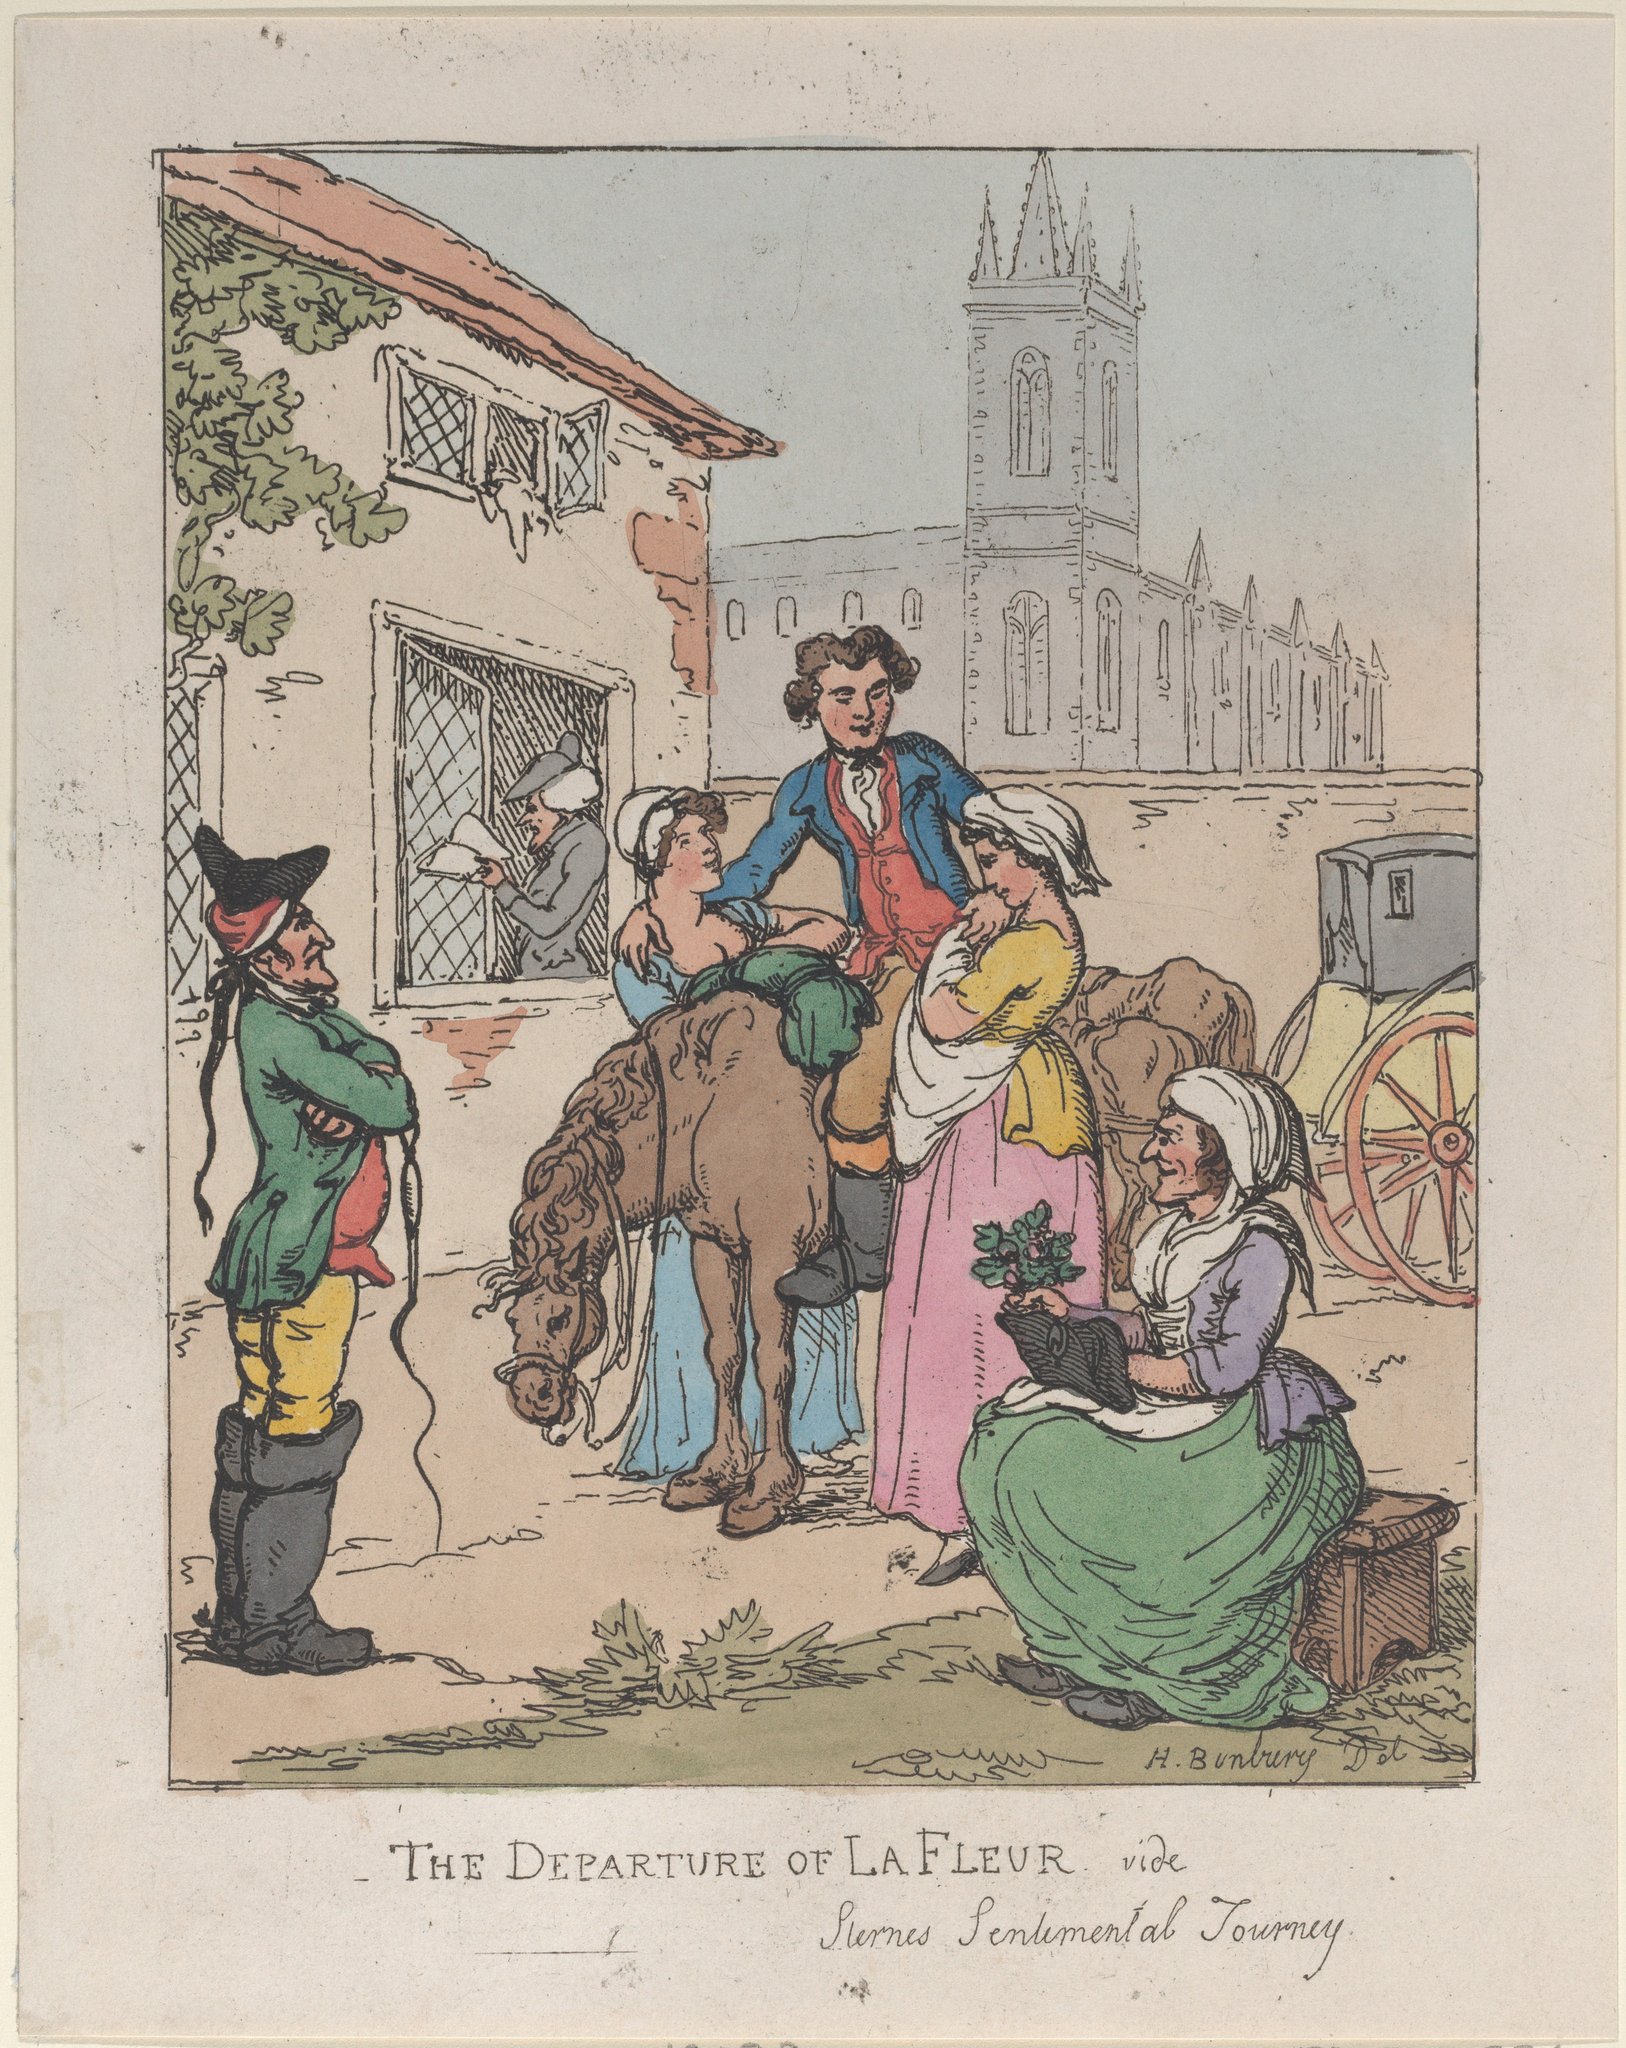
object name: print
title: The Departure of La Fleur, Sterne's "Sentimental Journey"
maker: thomas rowlandson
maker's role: artist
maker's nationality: british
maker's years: 1757-1827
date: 1809-1811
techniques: etching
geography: london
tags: men,women,horses